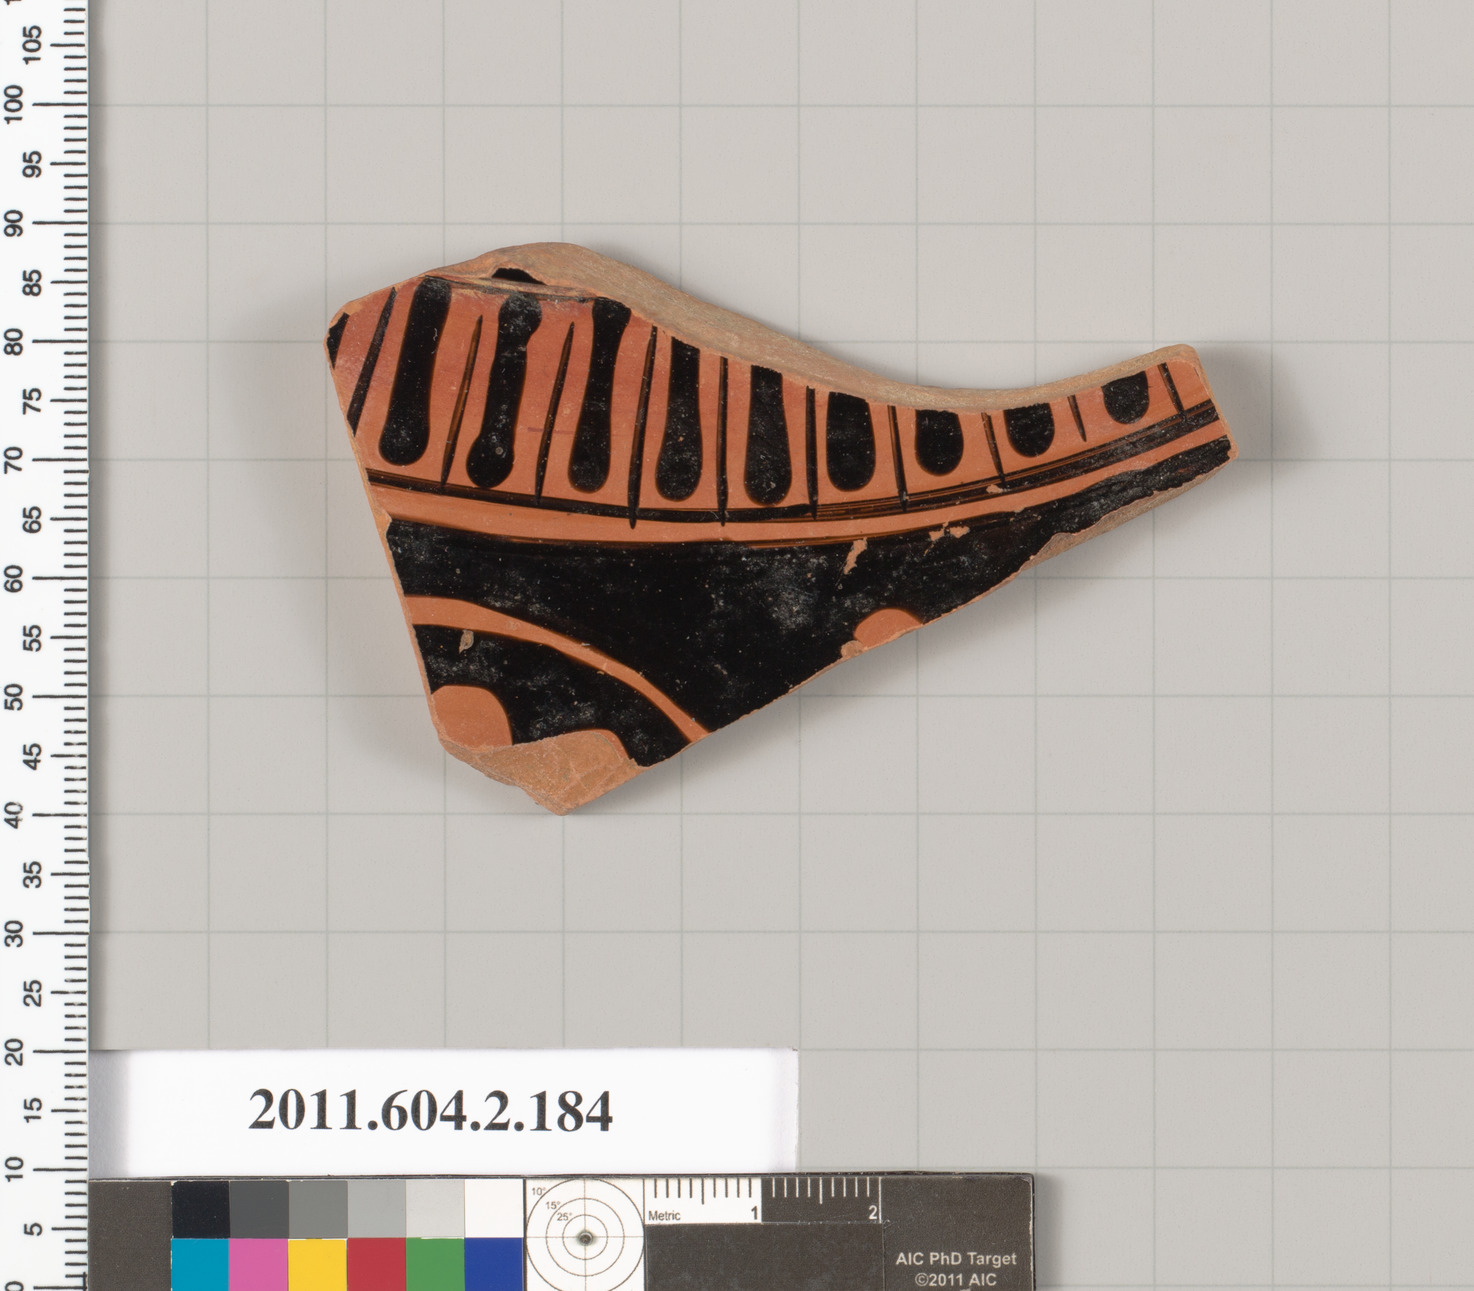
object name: stamnos fragment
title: Terracotta fragment of a stamnos (jar)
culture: greek, attic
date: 475-451 BCE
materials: terracotta